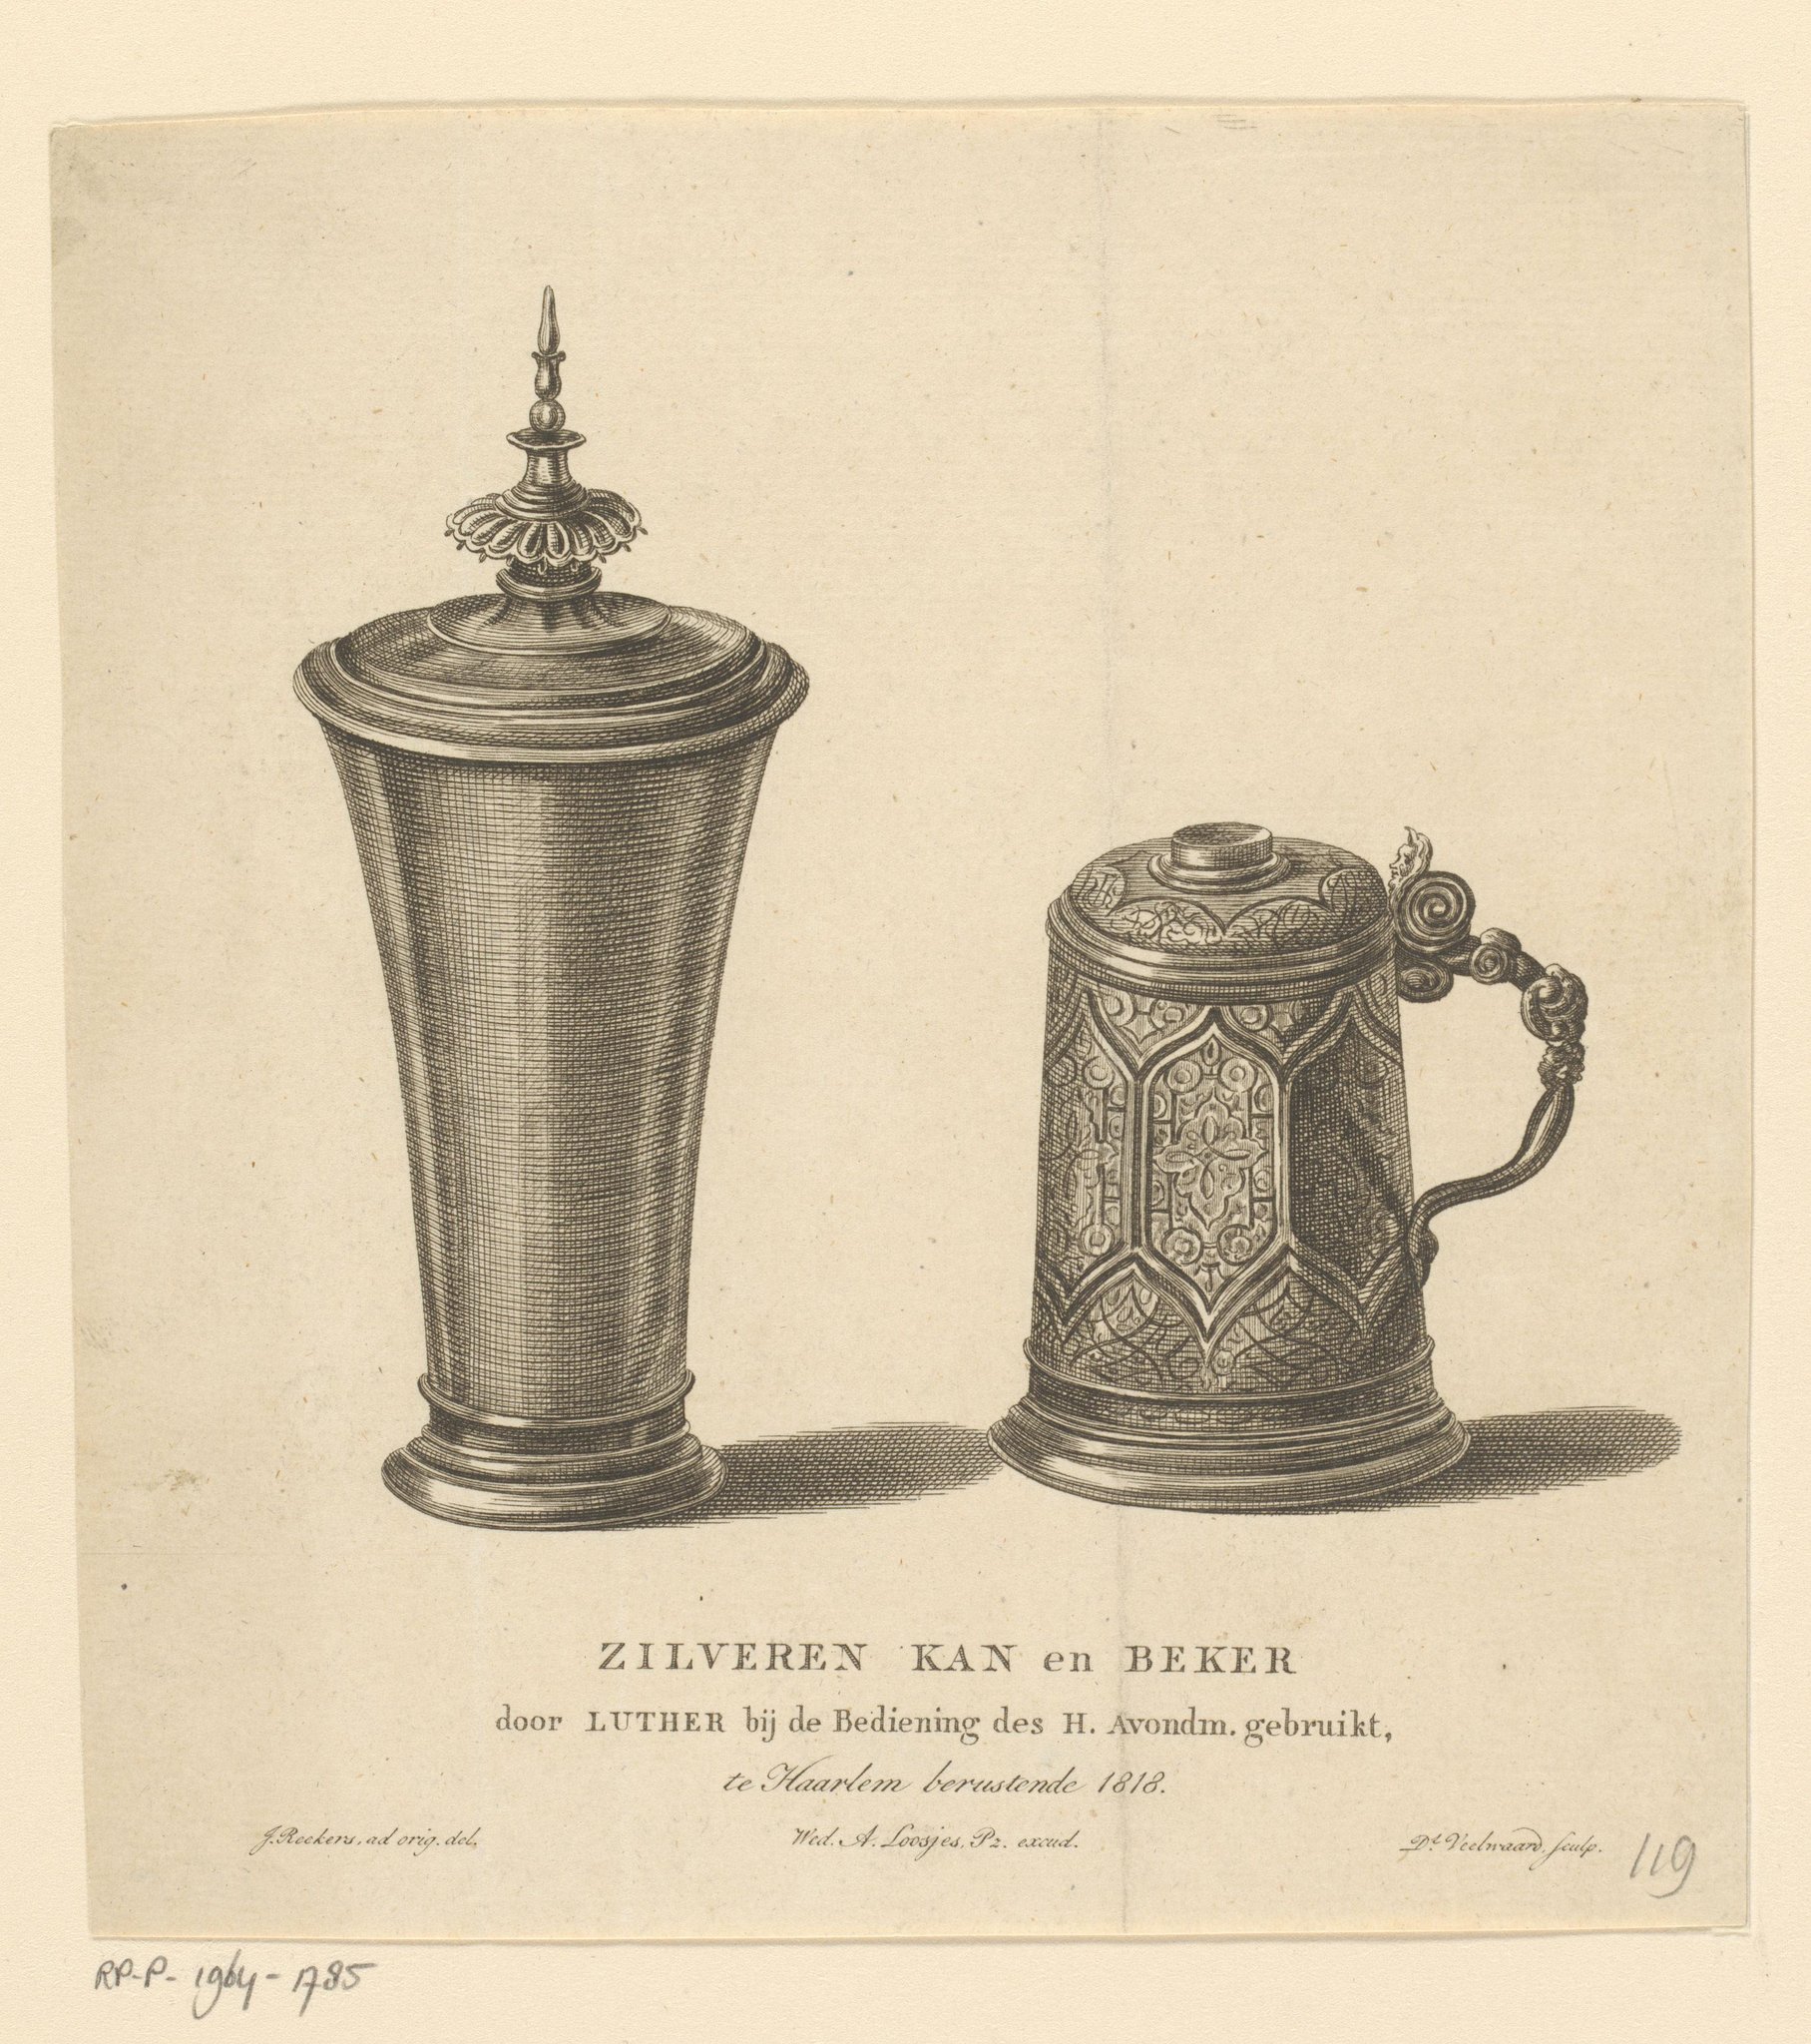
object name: print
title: Zilveren kan en beker door Luther bij de Bediening des H. Avondm. gebruikt, te Haarlem berustende 1818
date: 1818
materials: paper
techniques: engraving, etching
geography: haarlem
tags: priest, martin luther, communion ware (non-roman catholic)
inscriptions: collector's mark: Lugt 2760, collector's mark: Lugt 2228